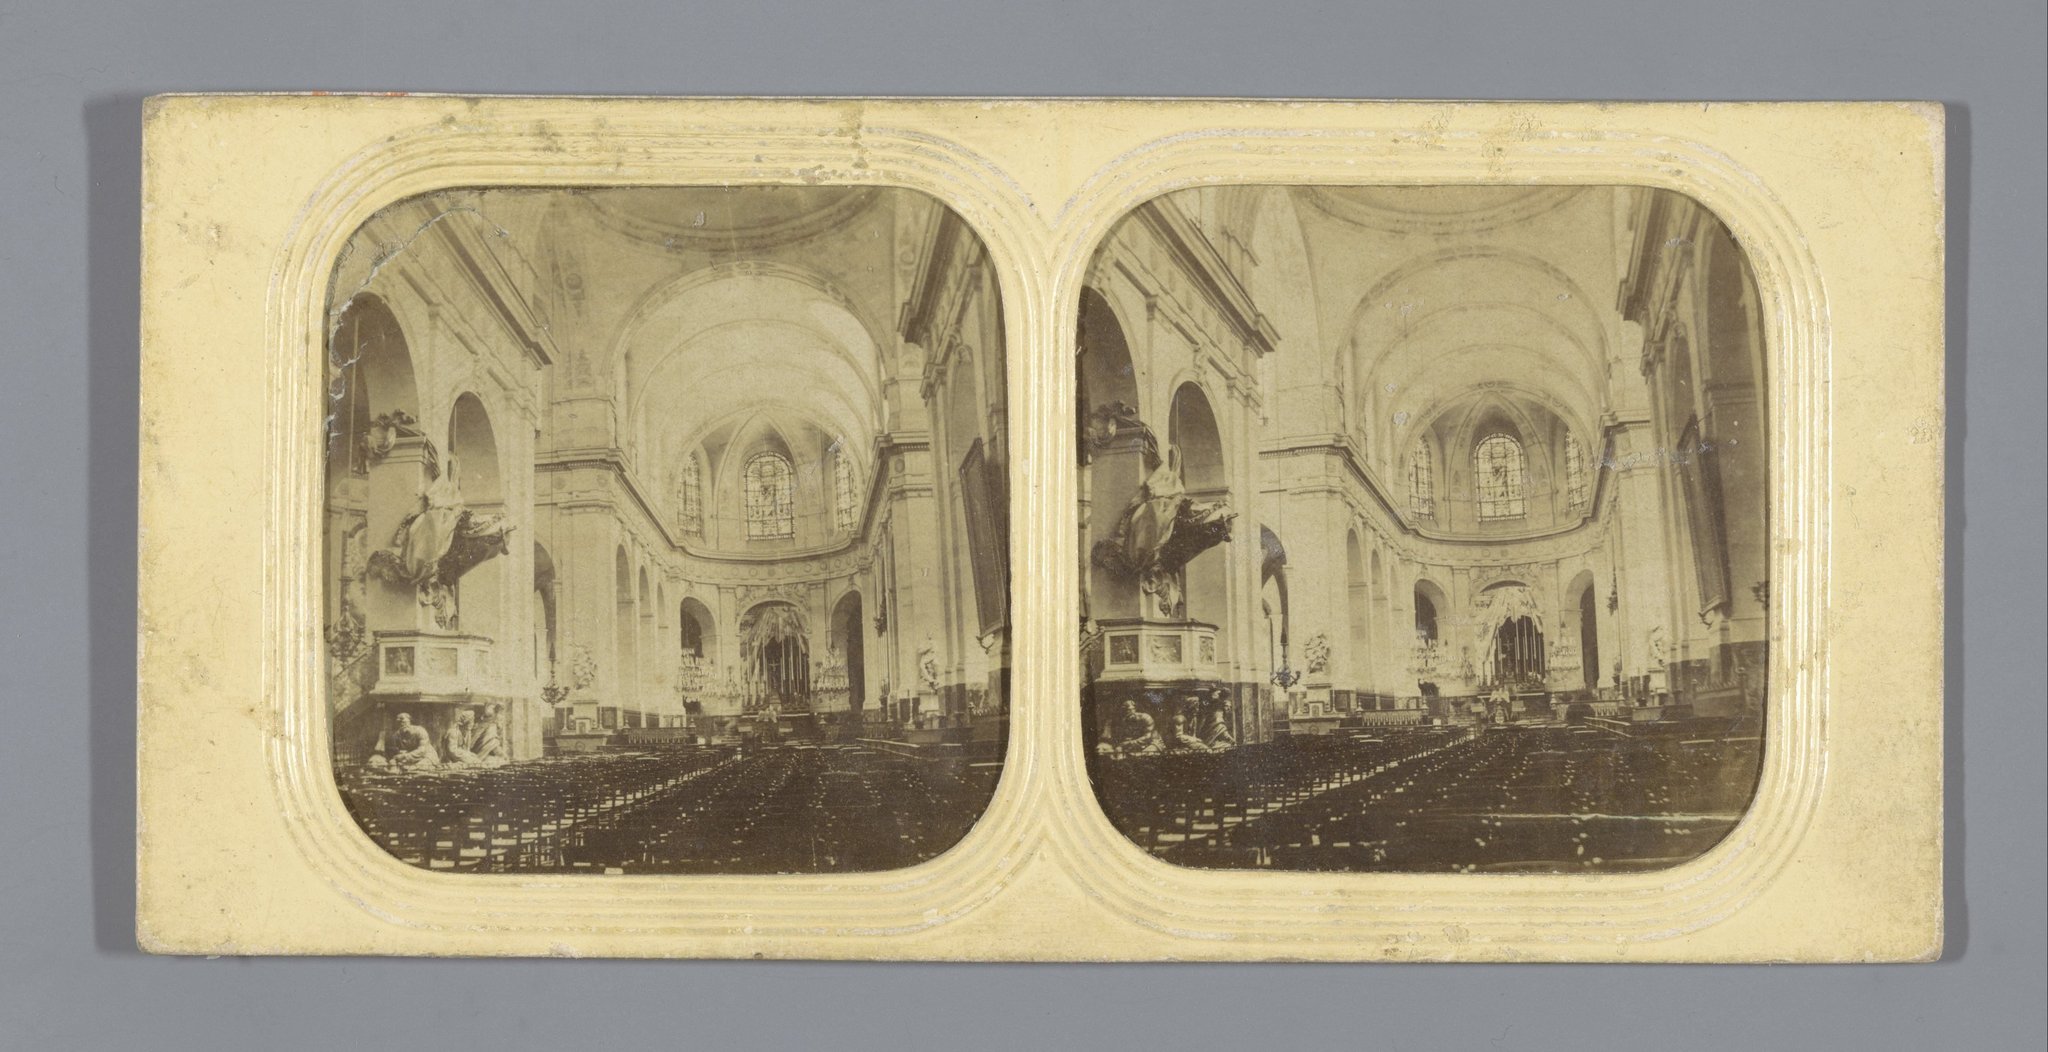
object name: tissue stereograph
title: Interieur van de Église Saint-Roch, Parijs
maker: Anonymous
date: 1855-1875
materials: cardboard, paper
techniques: albumen print, cutting, hand coloring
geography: paris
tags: interior of church, paris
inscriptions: inscription: ‘Anniv. Jan Henny 22’, number: ‘45’